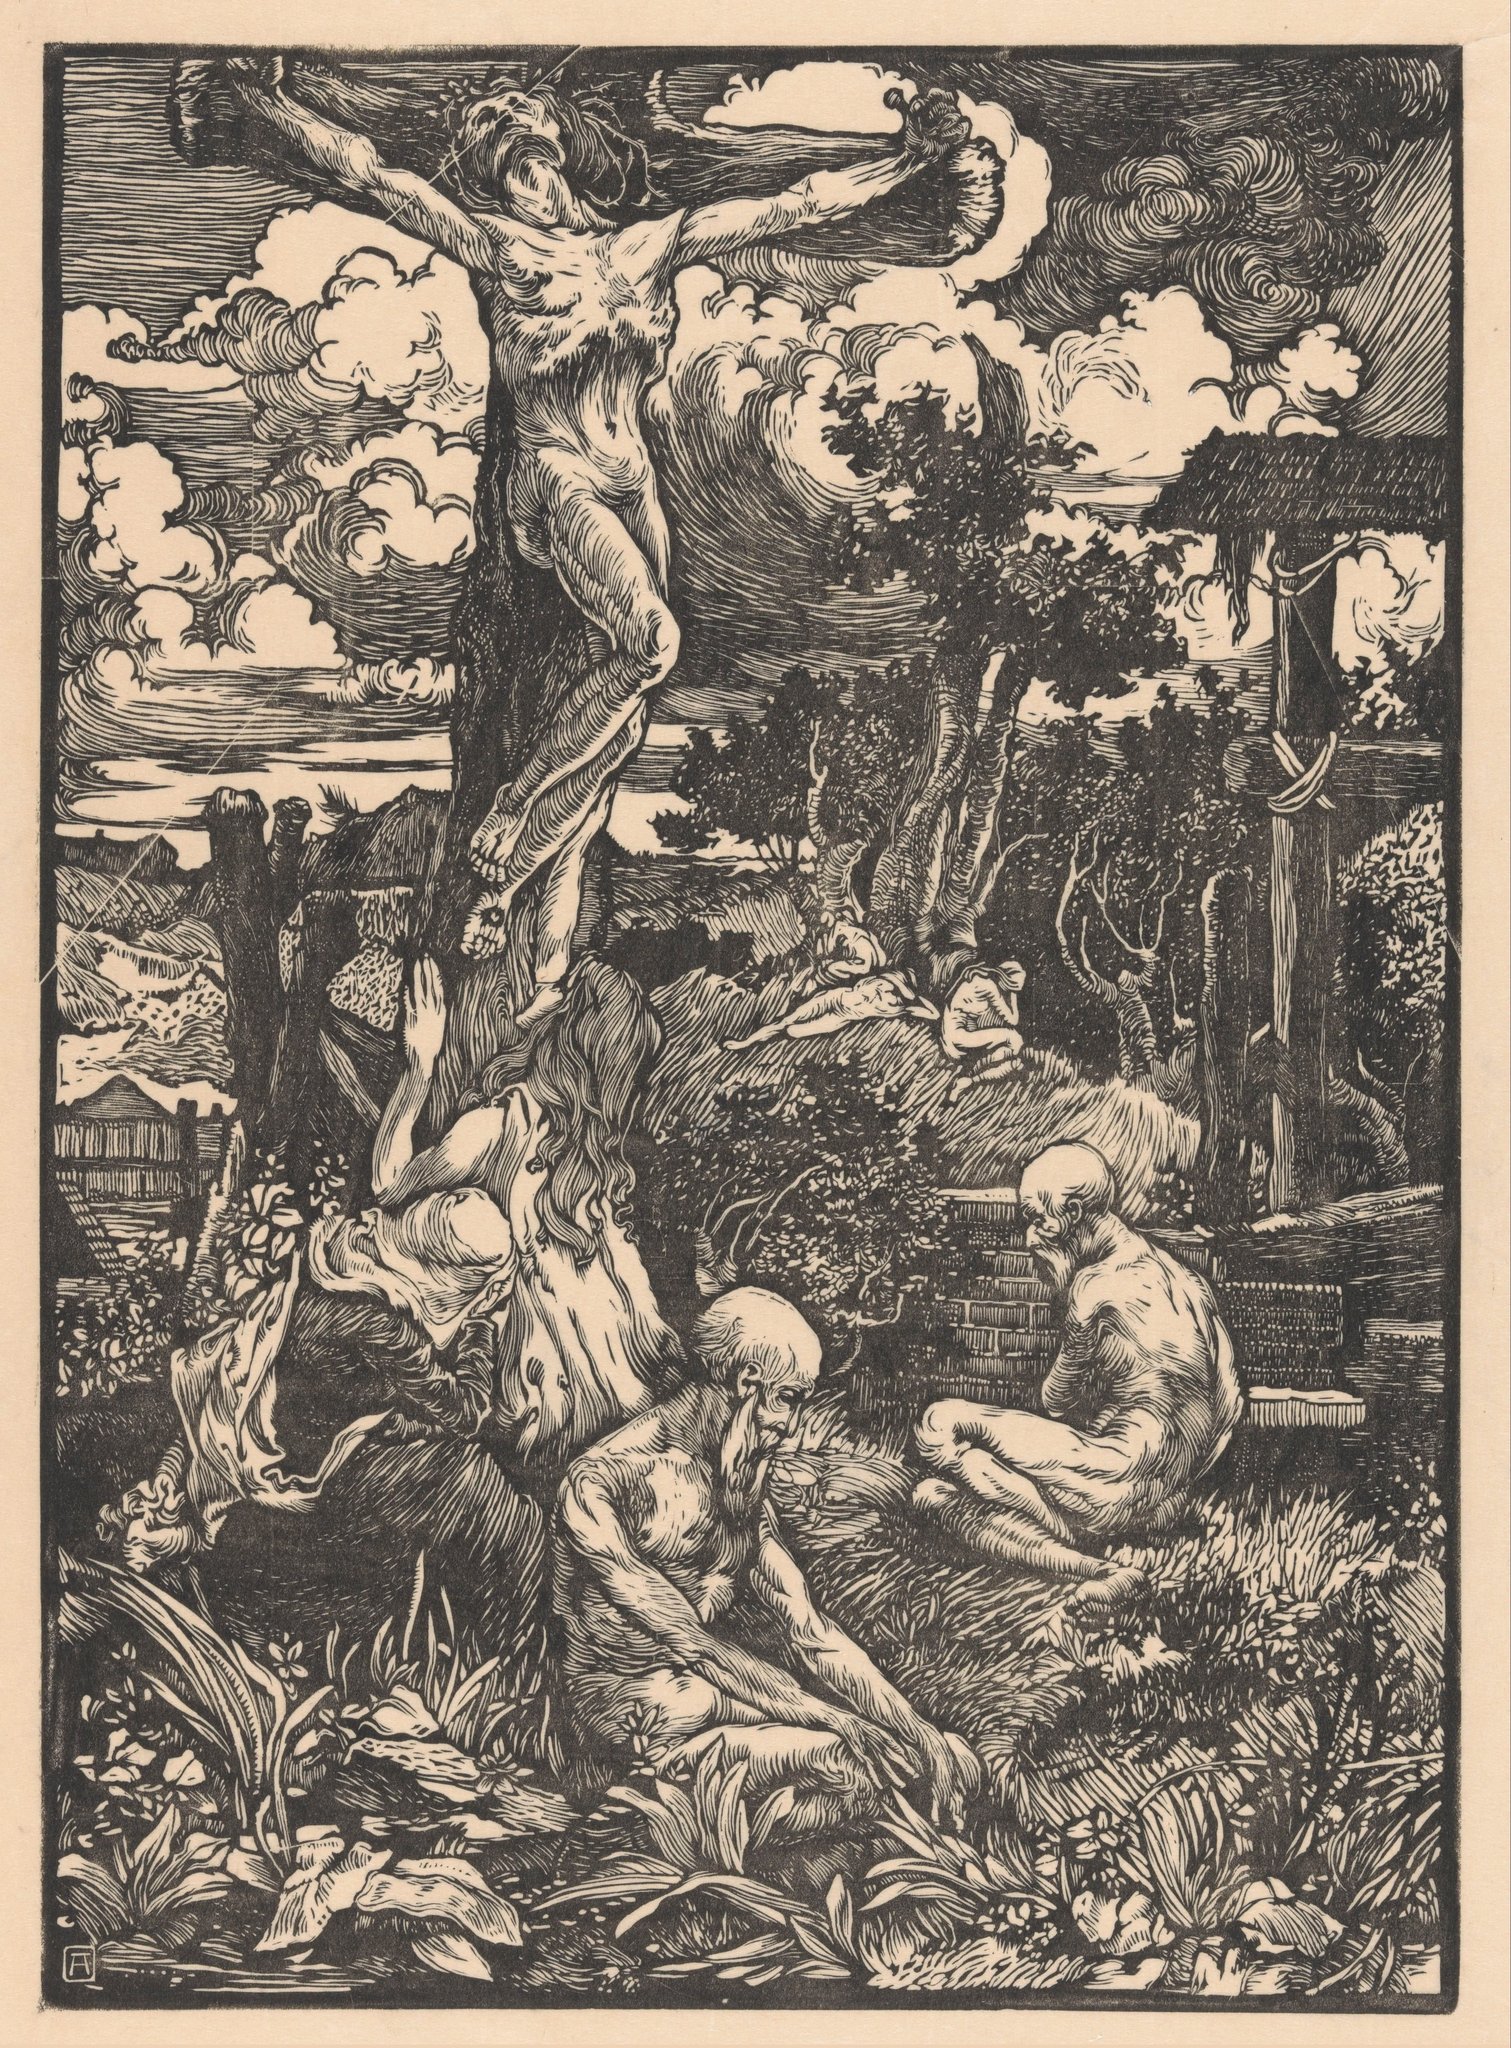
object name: print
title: Gekruisigde Christus in heuvellandschap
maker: johannes josephus aarts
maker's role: draughtsman, print maker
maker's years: 1871-1934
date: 1881-1934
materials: paper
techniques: woodcut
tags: low hill country - hh - ideal landscapes, violent death by crucifixion, man (showing himself) undressed, quasi-nude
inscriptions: collector's mark: Lugt 2166, collector's mark: Lugt 2760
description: Christus is naakt vastgespijkerd aan het kruis. Hij draagt een doornenkrans. Aan de voet van het kruis bevinden zich twee vrouwen in gewaden en twee naakte, bebaarde mannen. Op een heuvel op de achtergrond nog drie naakte figuren.